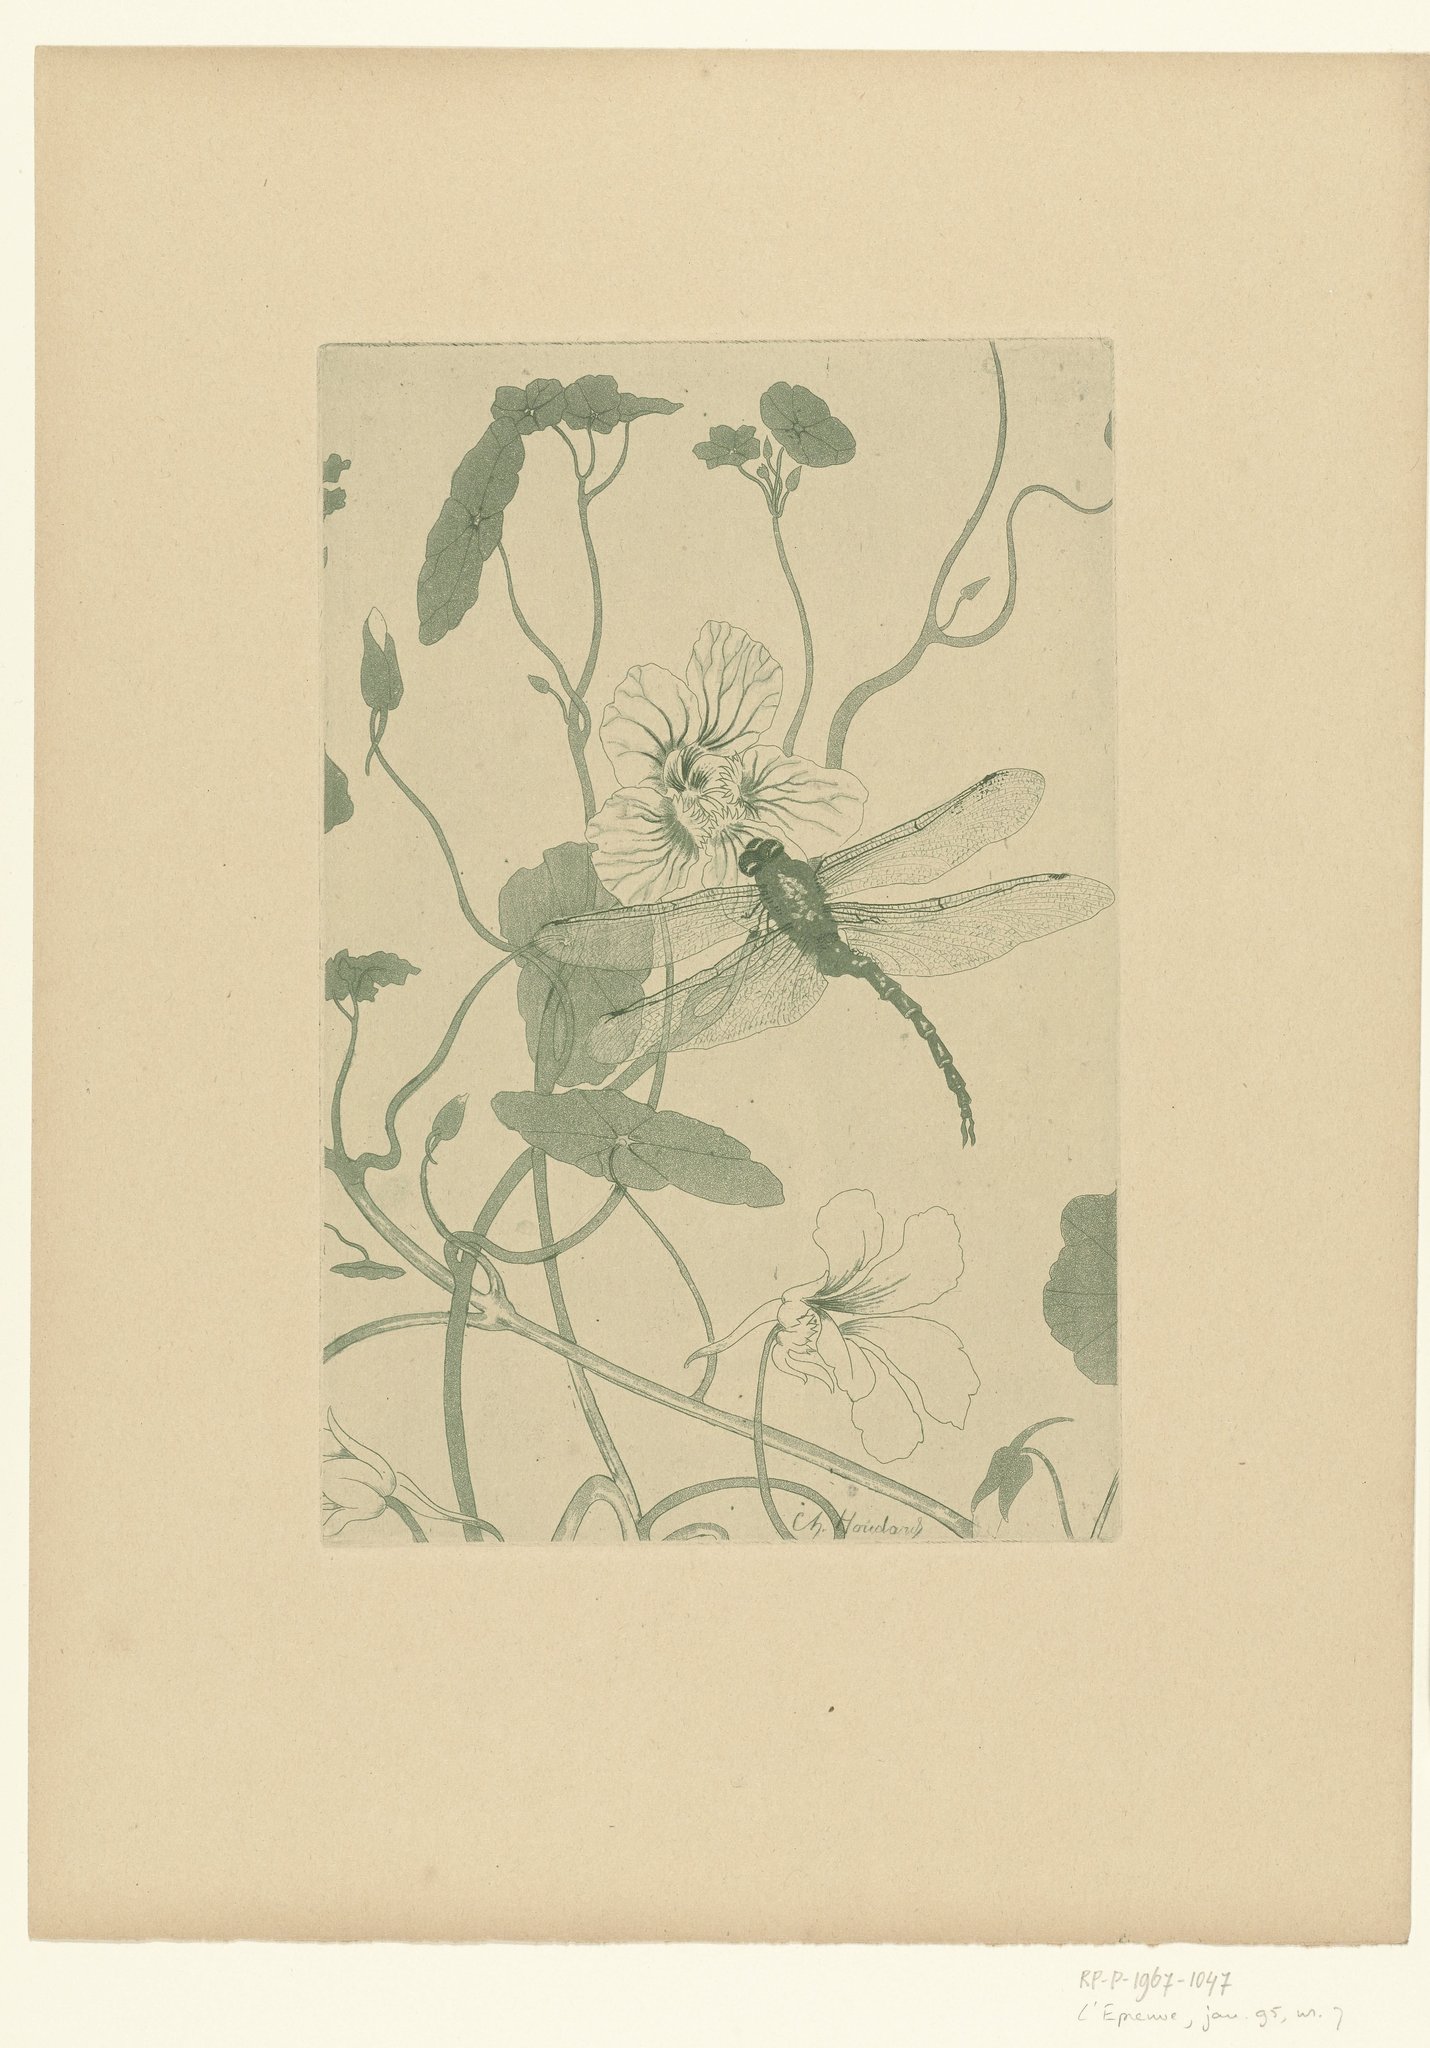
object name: print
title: L'Epreuve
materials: paper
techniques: aquatint, etching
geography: paris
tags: insects: dragon-fly, plants; vegetation (+ flowers, blossom, blossoming)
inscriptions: collector's mark: Lugt 2228, collector's mark: Lugt 2760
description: Verschenen in album met tien originele prenten bij tijdschrift: L'Epreuve, januari 1895, prent nr. 7